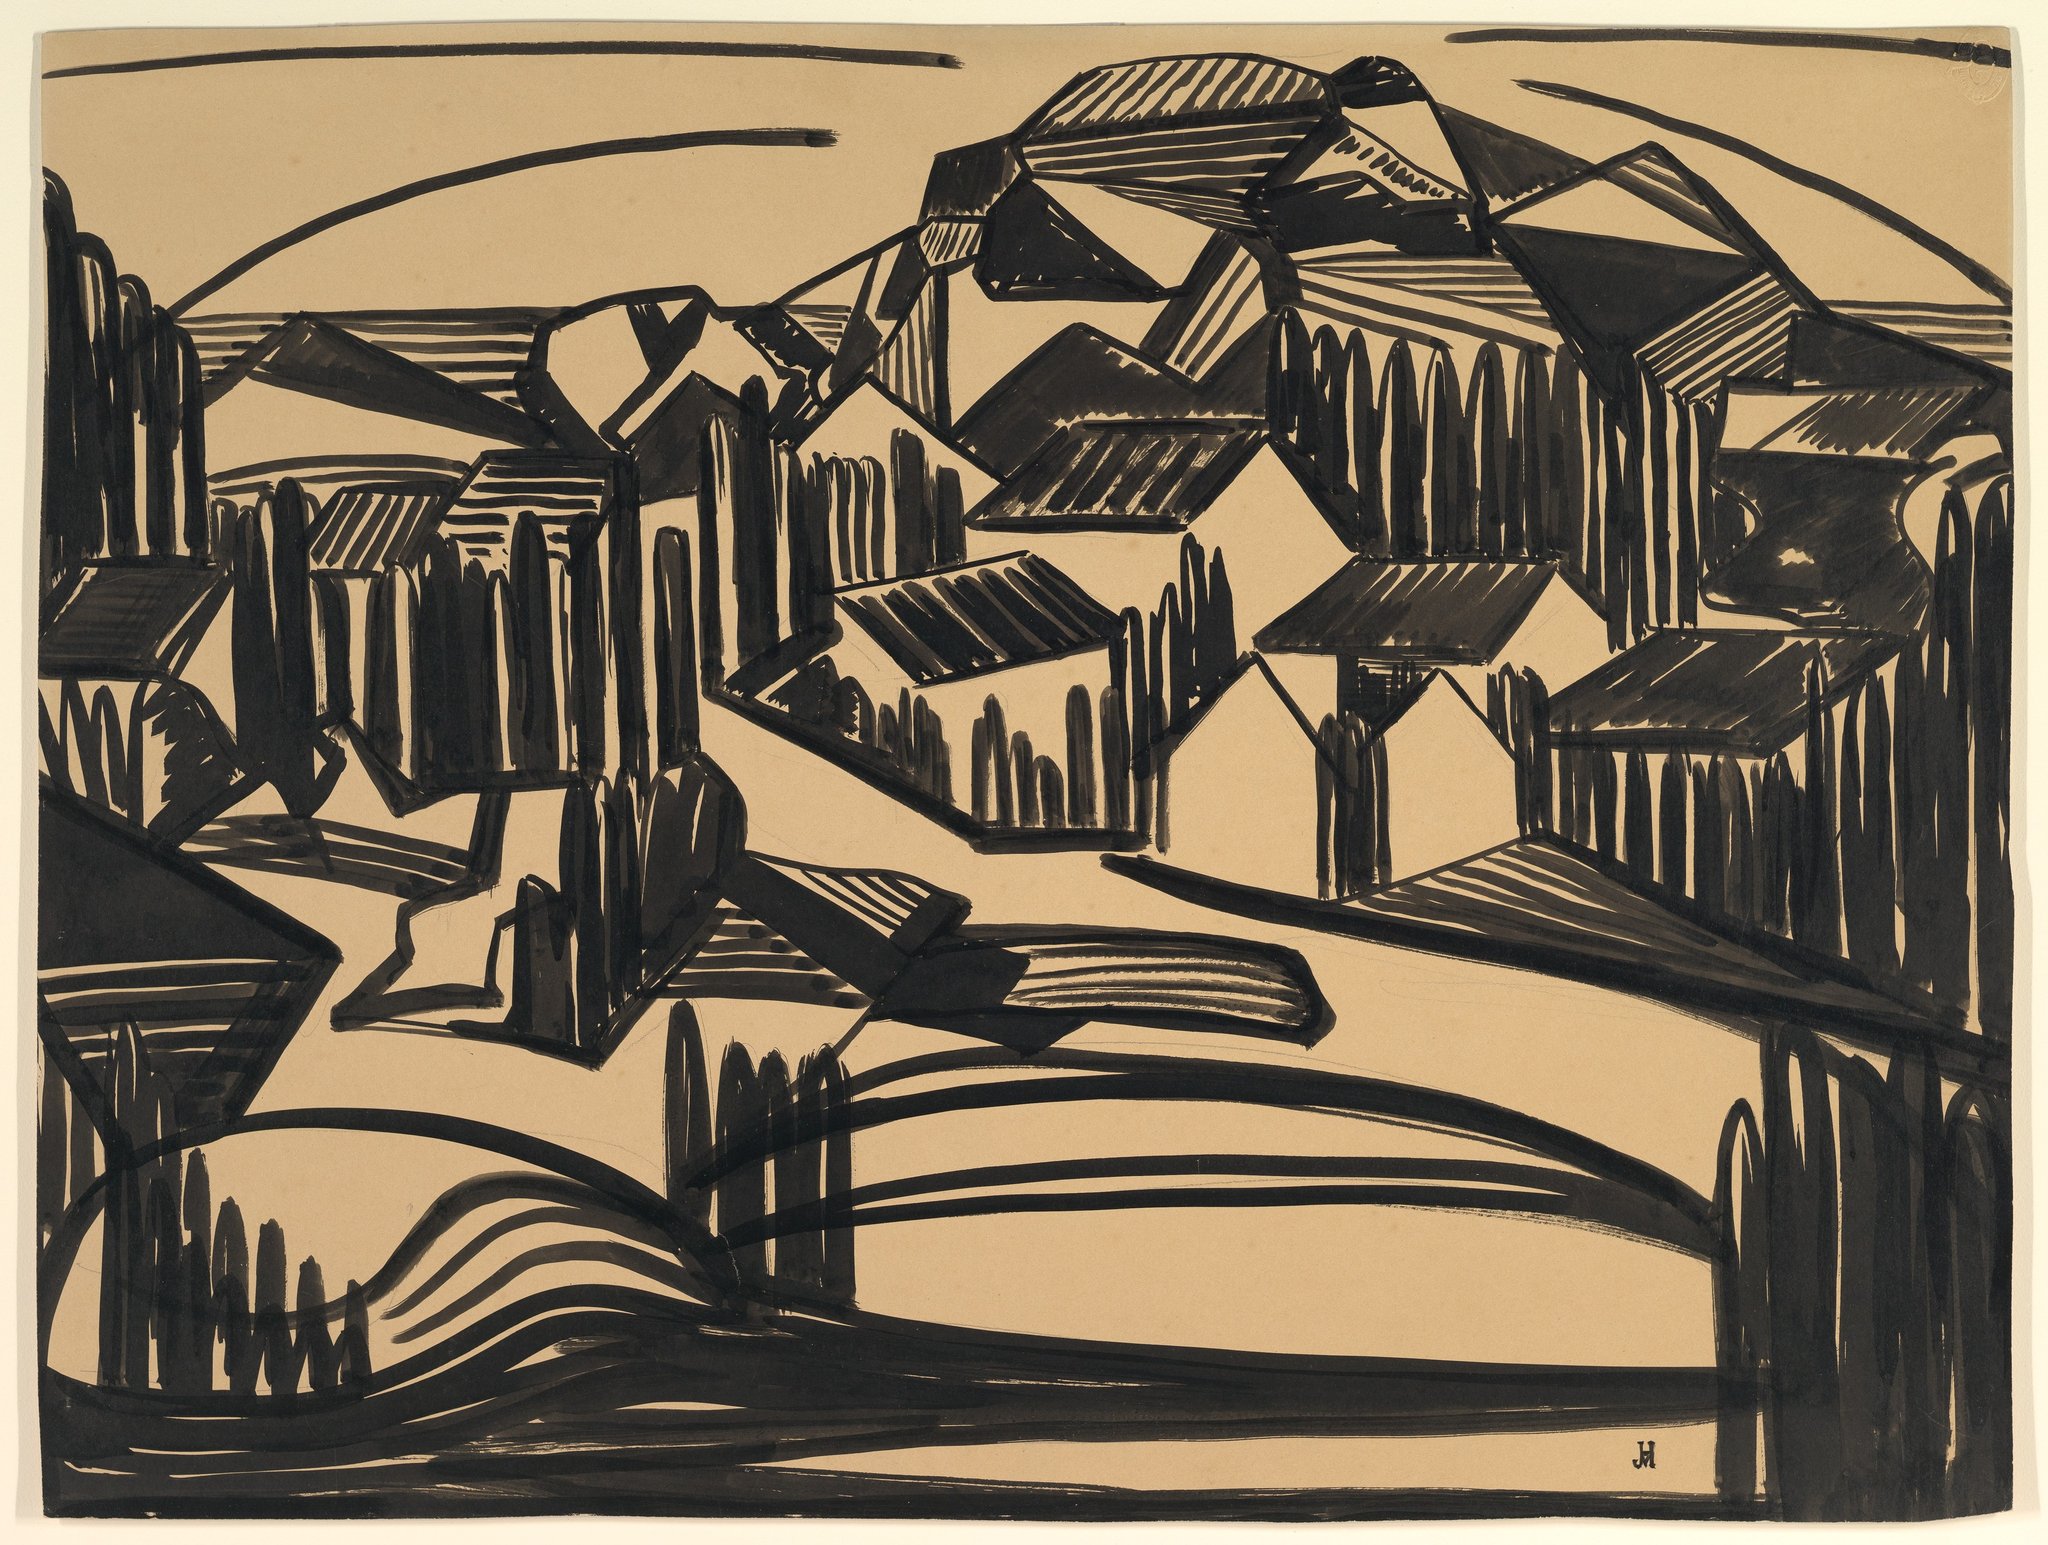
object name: drawing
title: Drawing 16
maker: jacoba van heemskerck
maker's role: artist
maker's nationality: dutch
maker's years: 1876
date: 1916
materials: ink, paper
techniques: brush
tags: landscapes